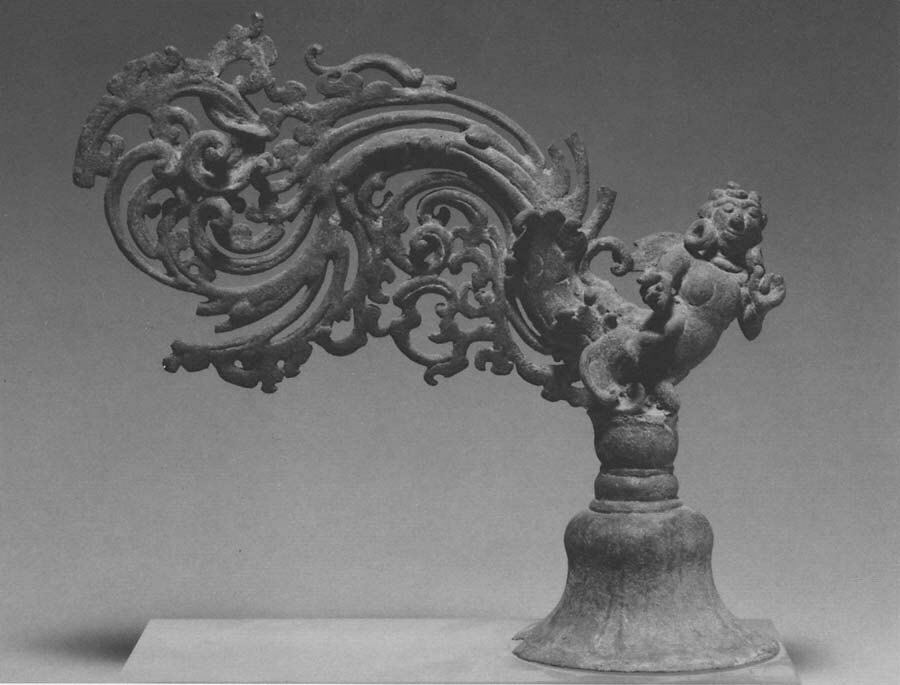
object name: finial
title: Finial with a Kinnari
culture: indonesian, javanese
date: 801-900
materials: bronze